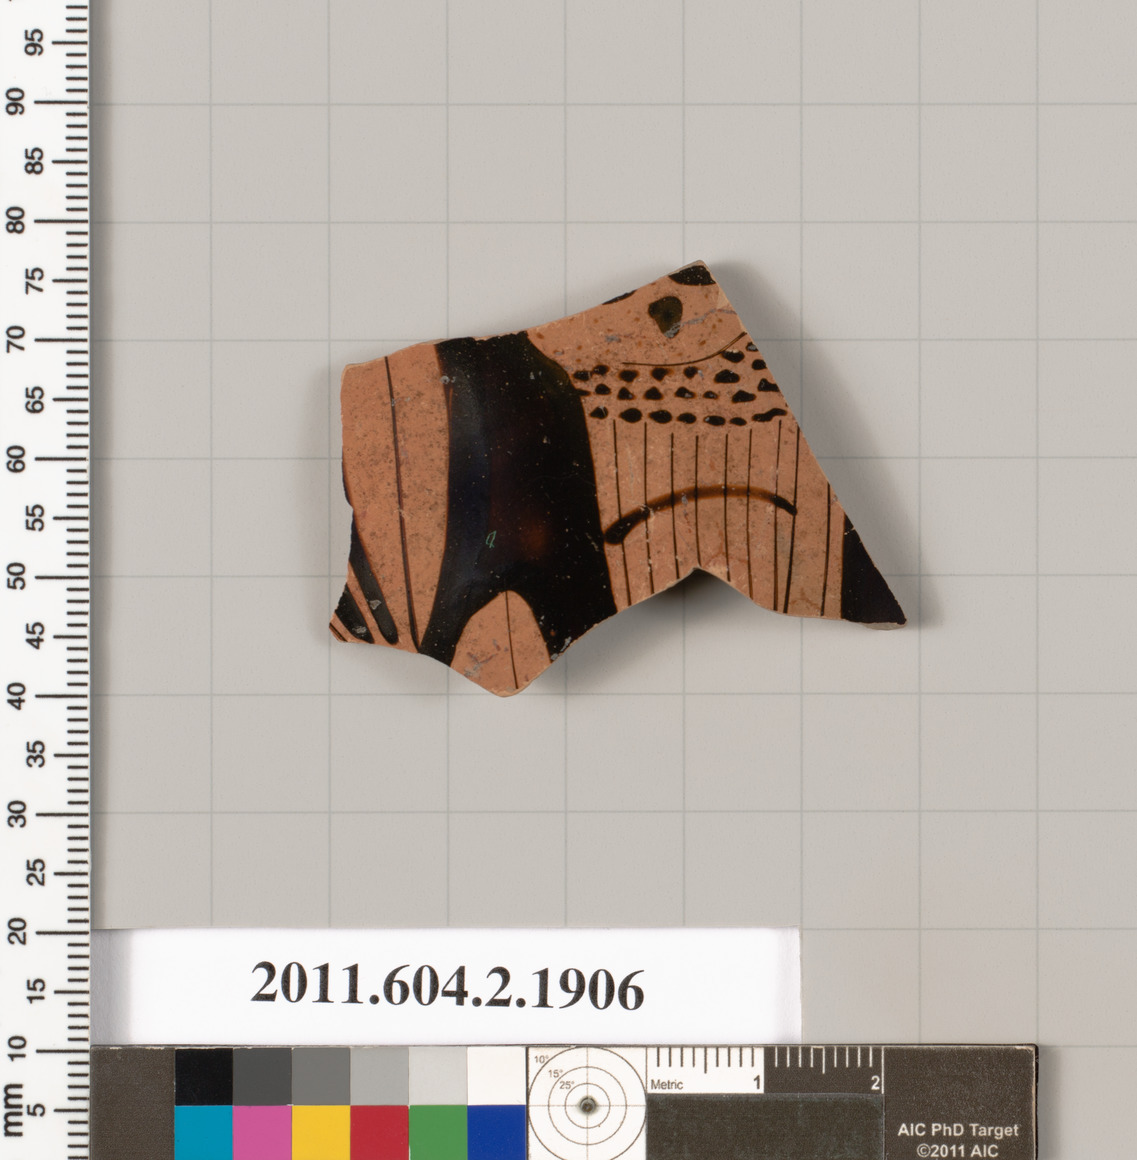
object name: skyphos fragment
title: Terracotta fragment of a skyphos (deep drinking cup)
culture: greek, attic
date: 460-430 BCE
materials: terracotta